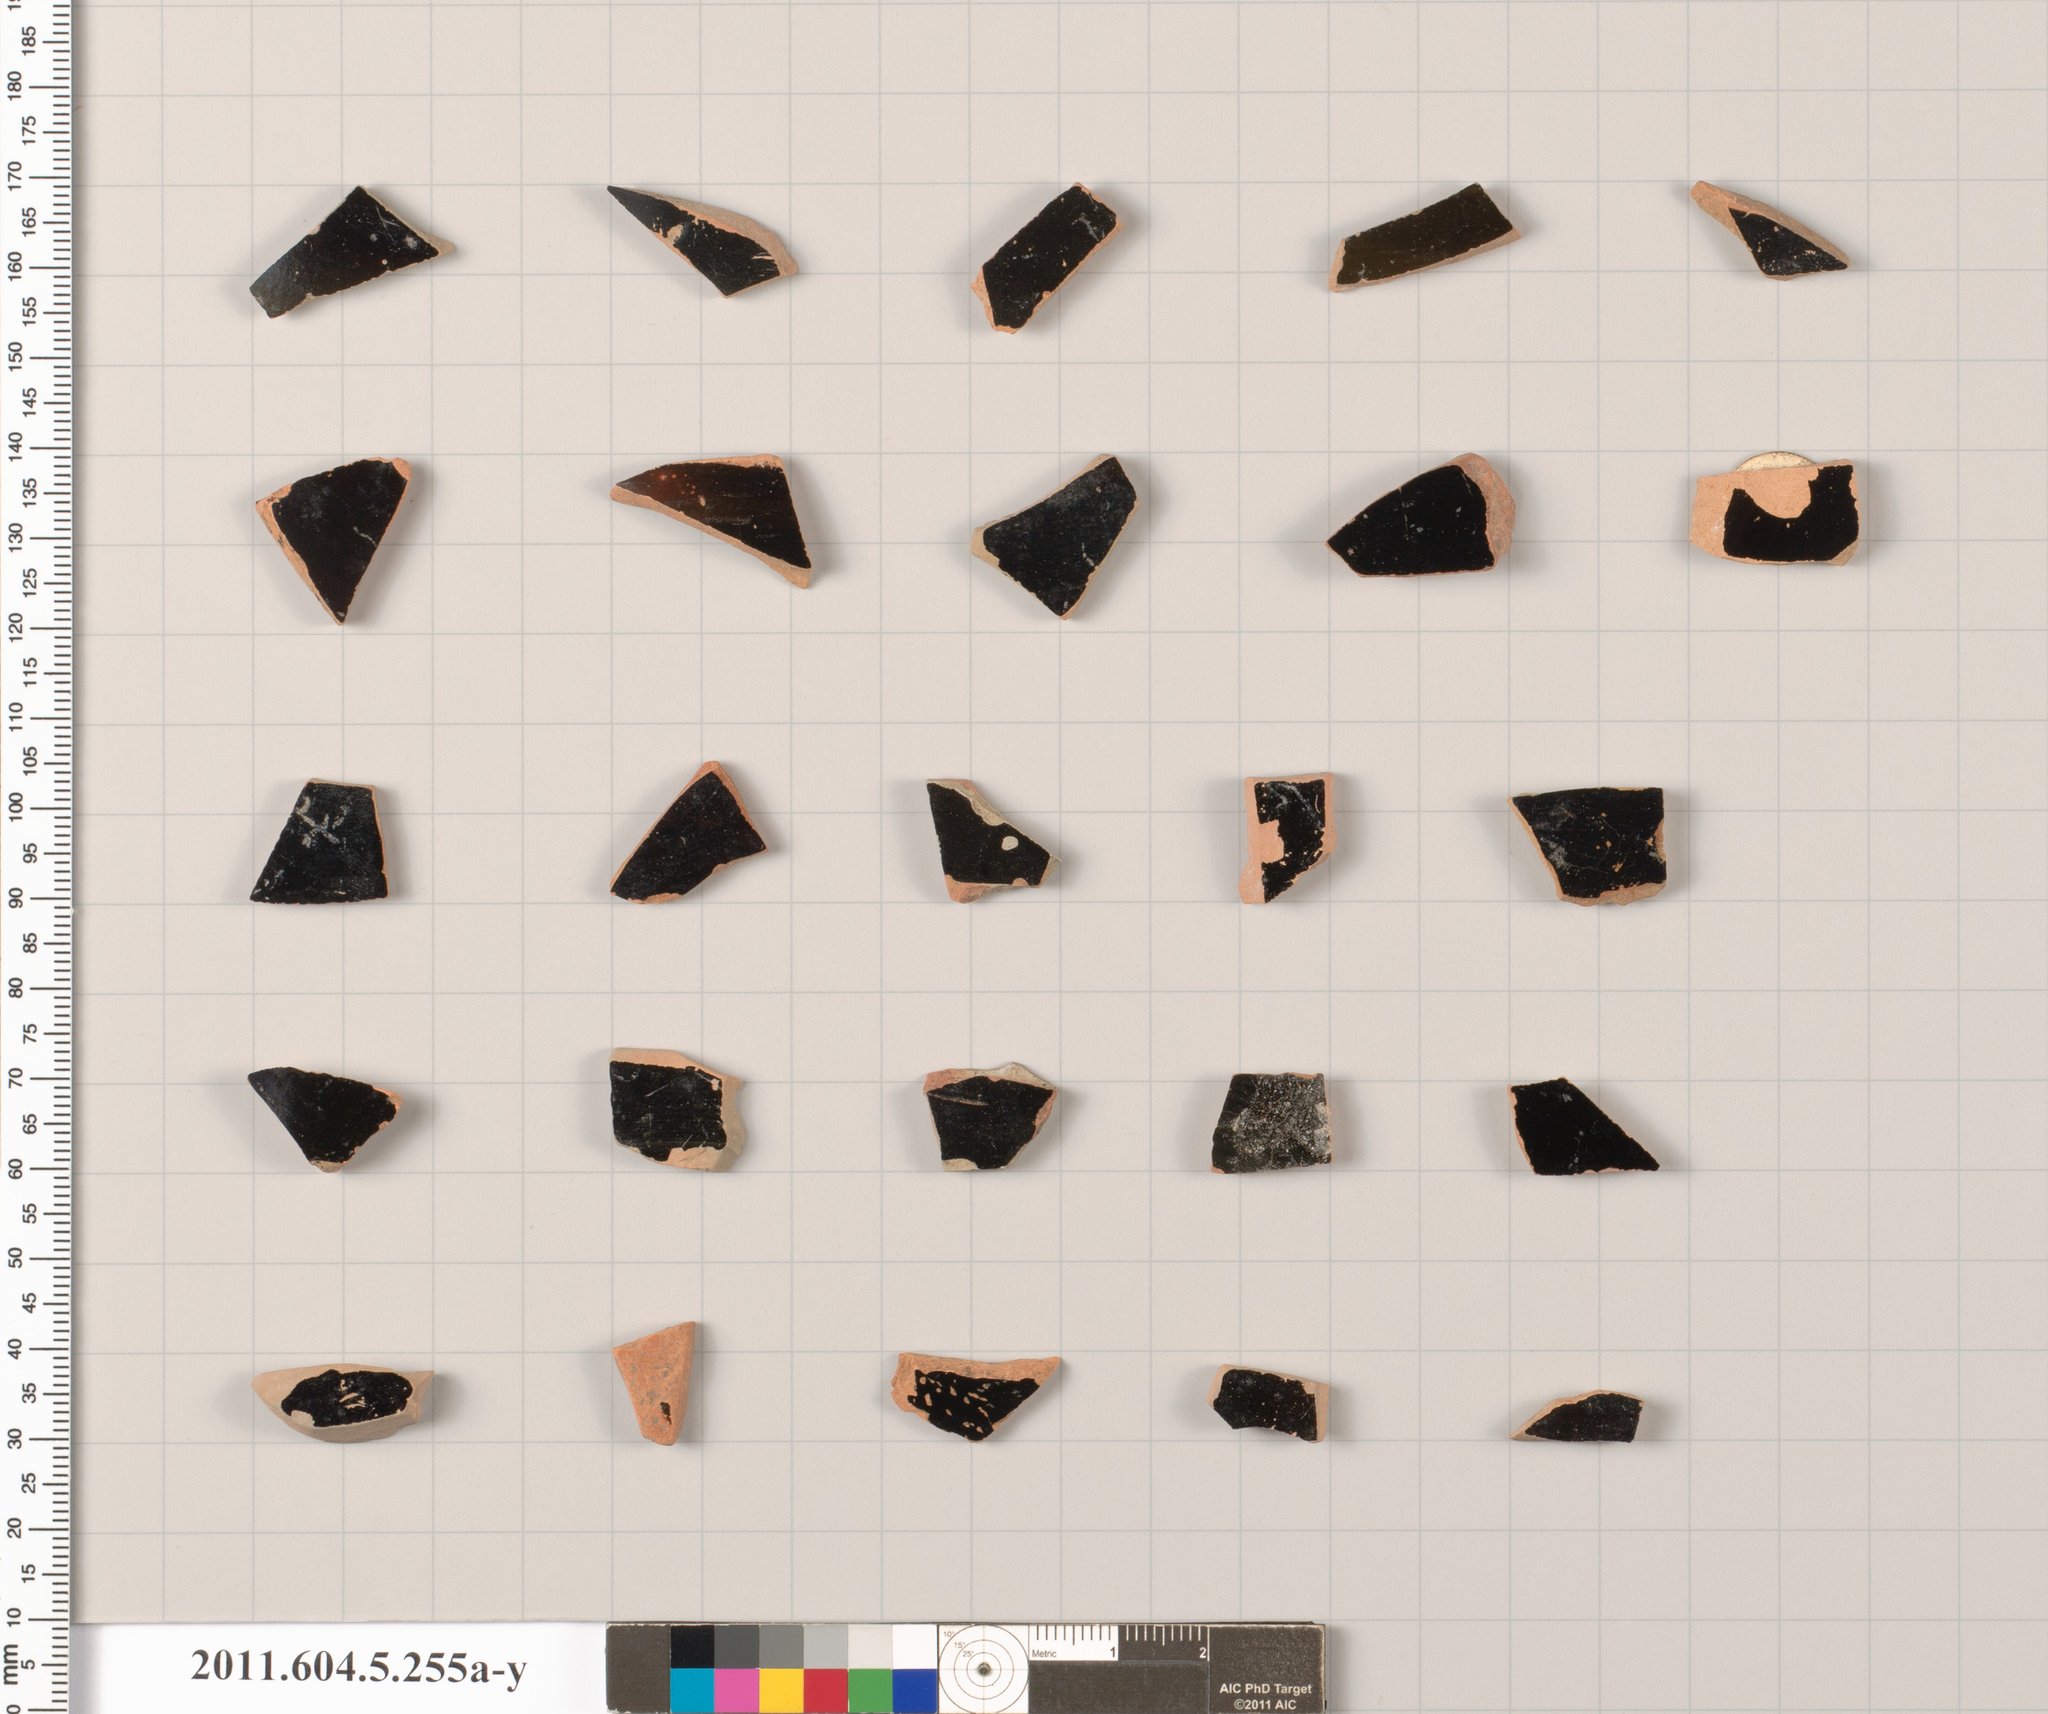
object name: kylix fragment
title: Terracotta fragments of kylikes (drinking cups)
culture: greek, attic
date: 600-401 BCE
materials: terracotta